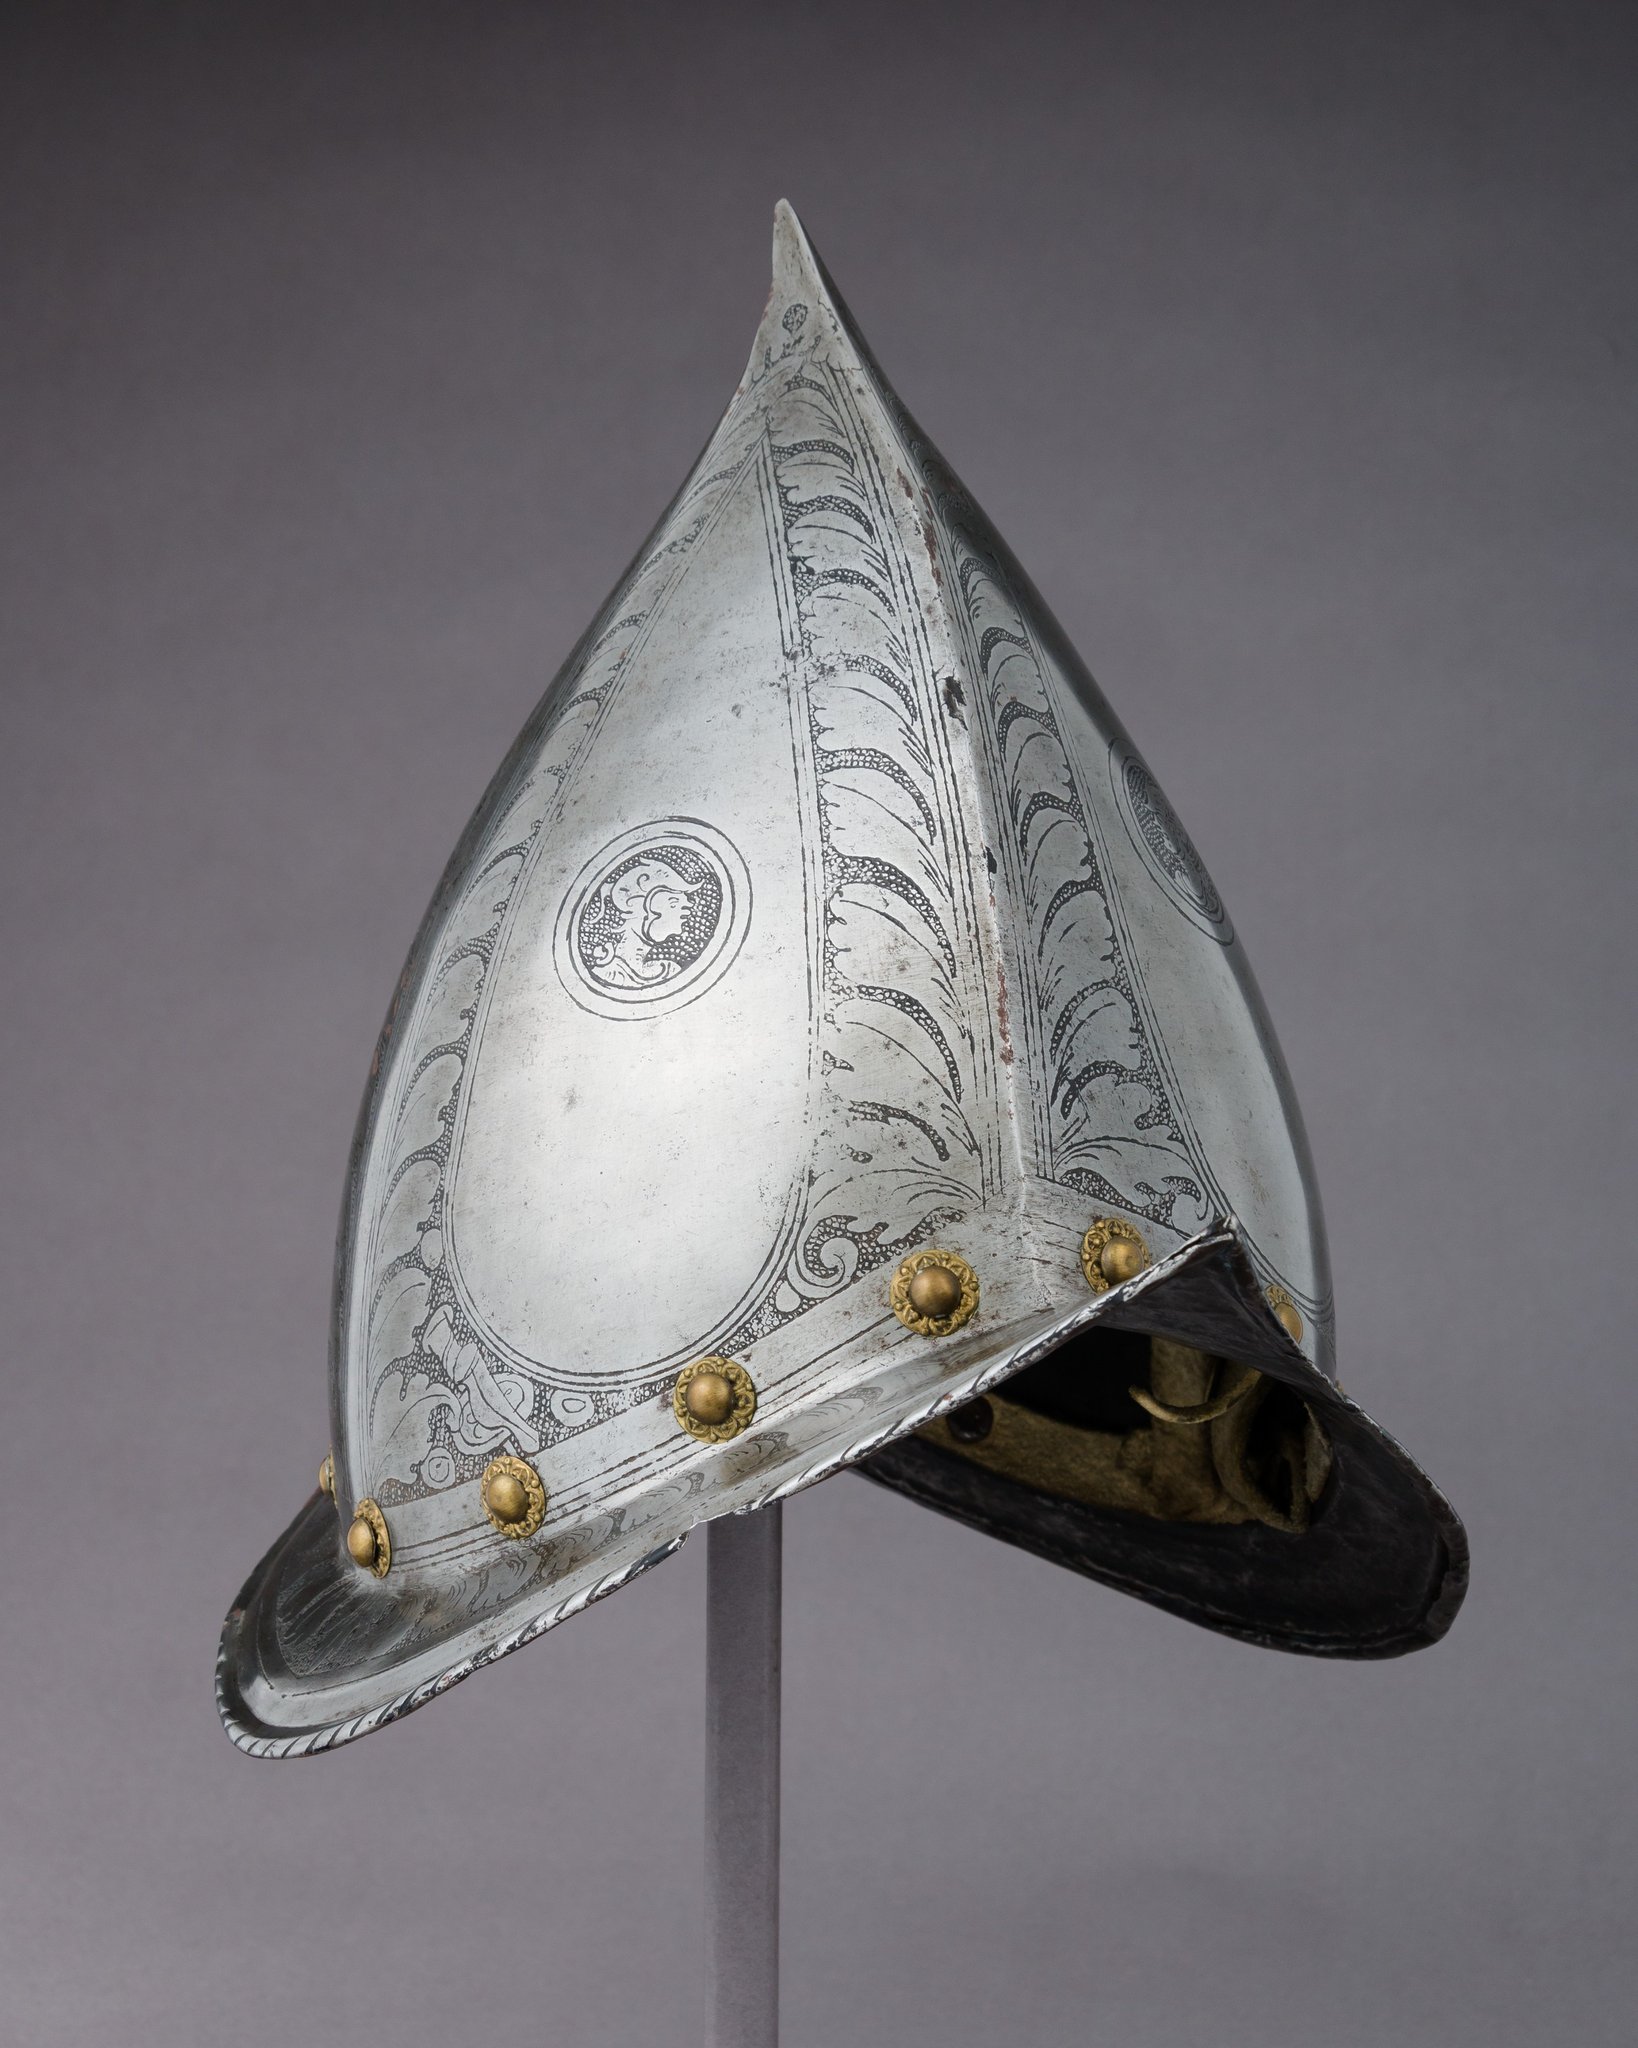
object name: morion cabasset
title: Morion-Cabasset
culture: italian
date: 1501-1600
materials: brass, leather, steel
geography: italy